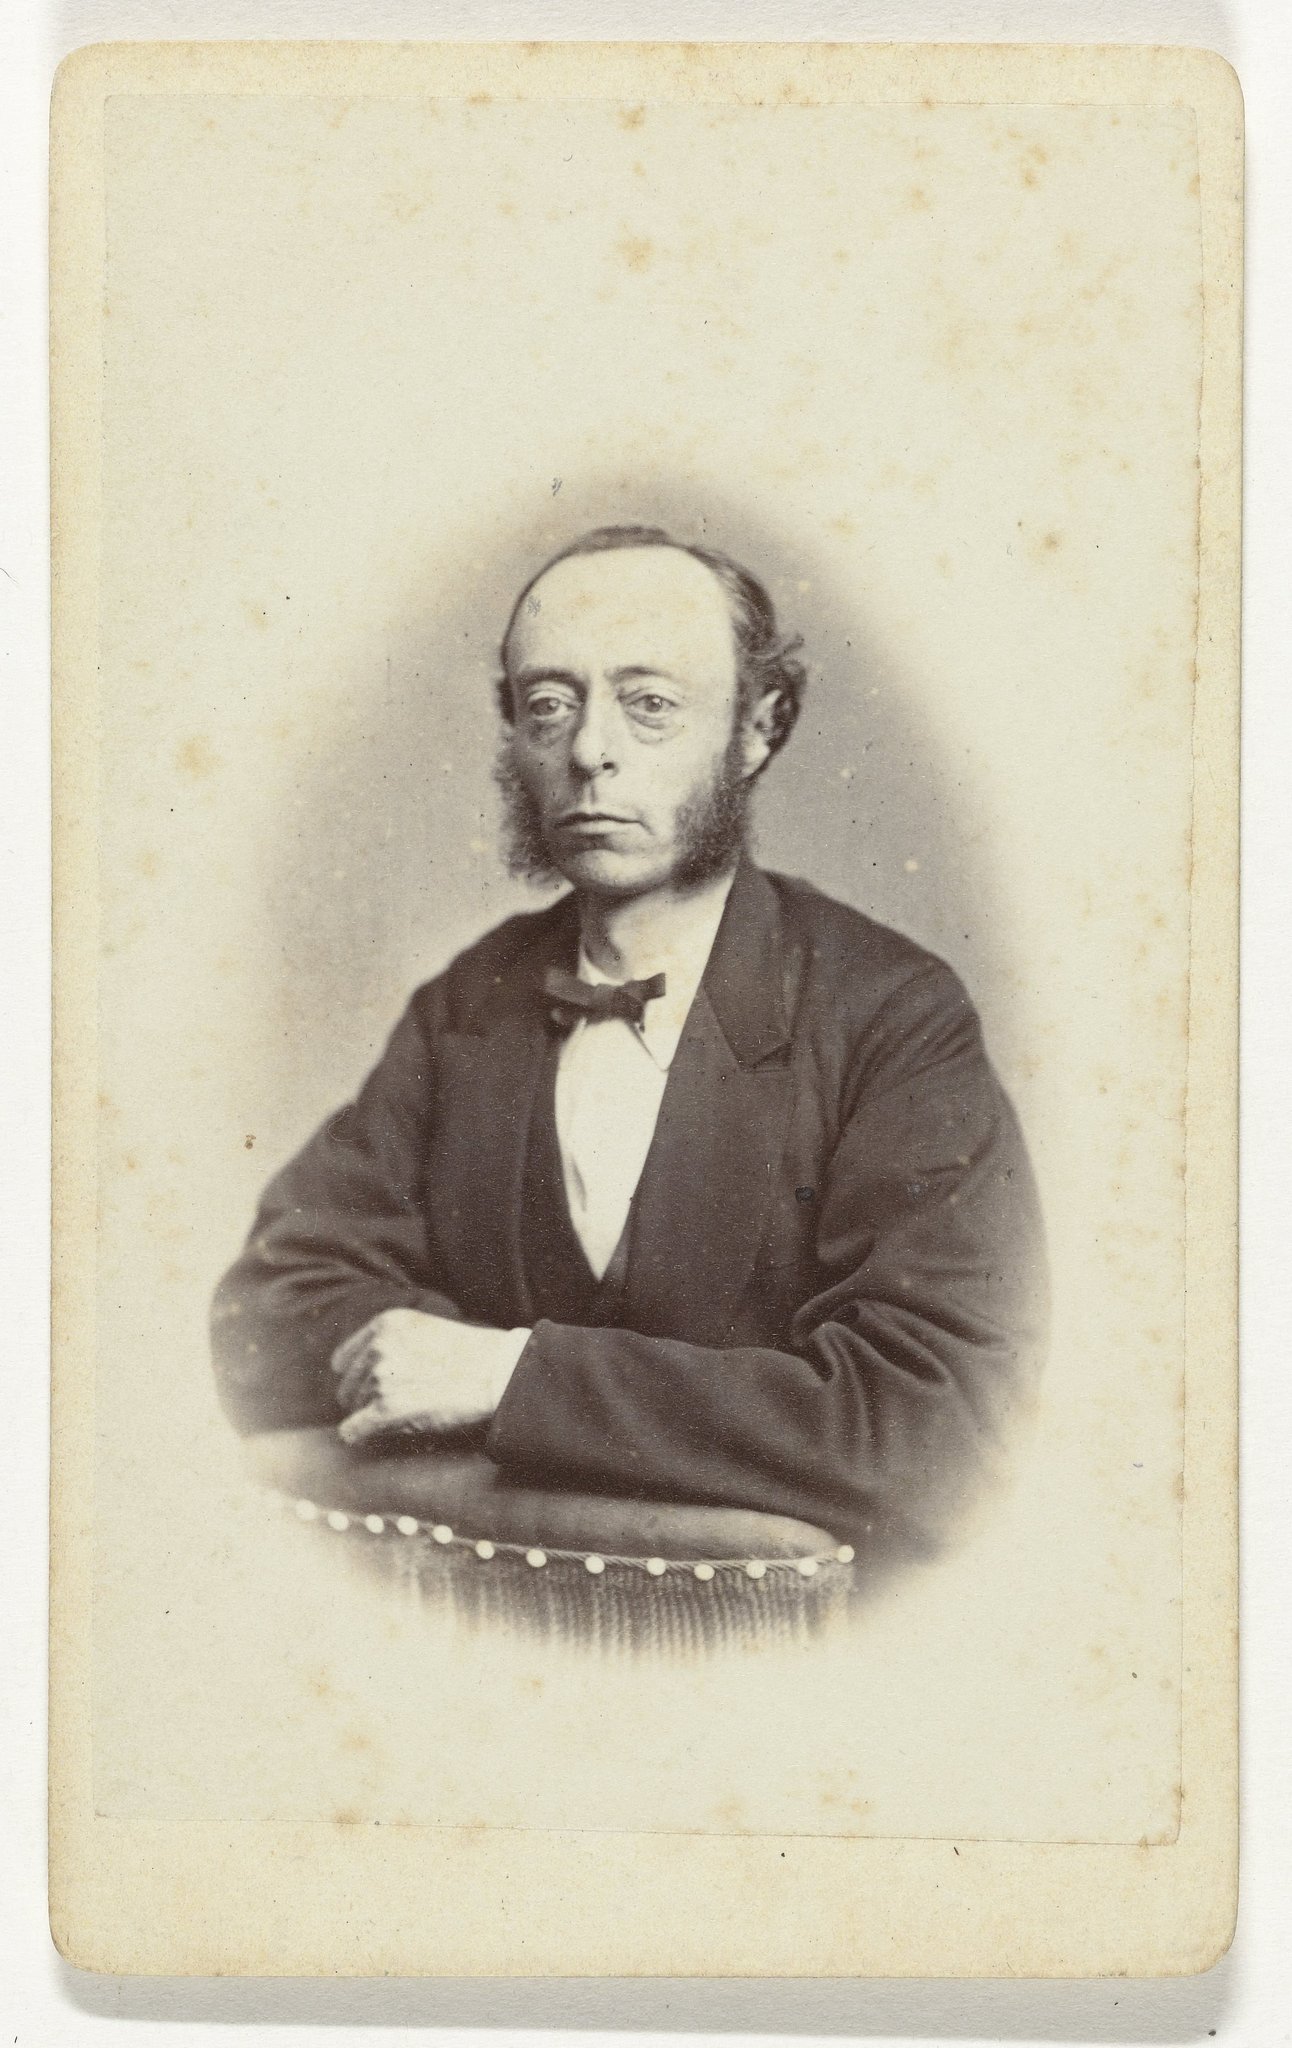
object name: photograph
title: Portret van een man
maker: willem gerhardus kuijer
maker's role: fotograaf, hoffotograaf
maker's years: 1834-1899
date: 1873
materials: cardboard, paper, photographic support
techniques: albumen print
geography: amsterdam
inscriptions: address: ‘Photographisch/Atelier/W.G.Kuijer/Rozengracht/tusschen de 1e en 2e Bloemdwarsstraat/DD.455/Amsterdam’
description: Man met pluizige bakkebaarden, leunend, ten halven lijve iets naar links.